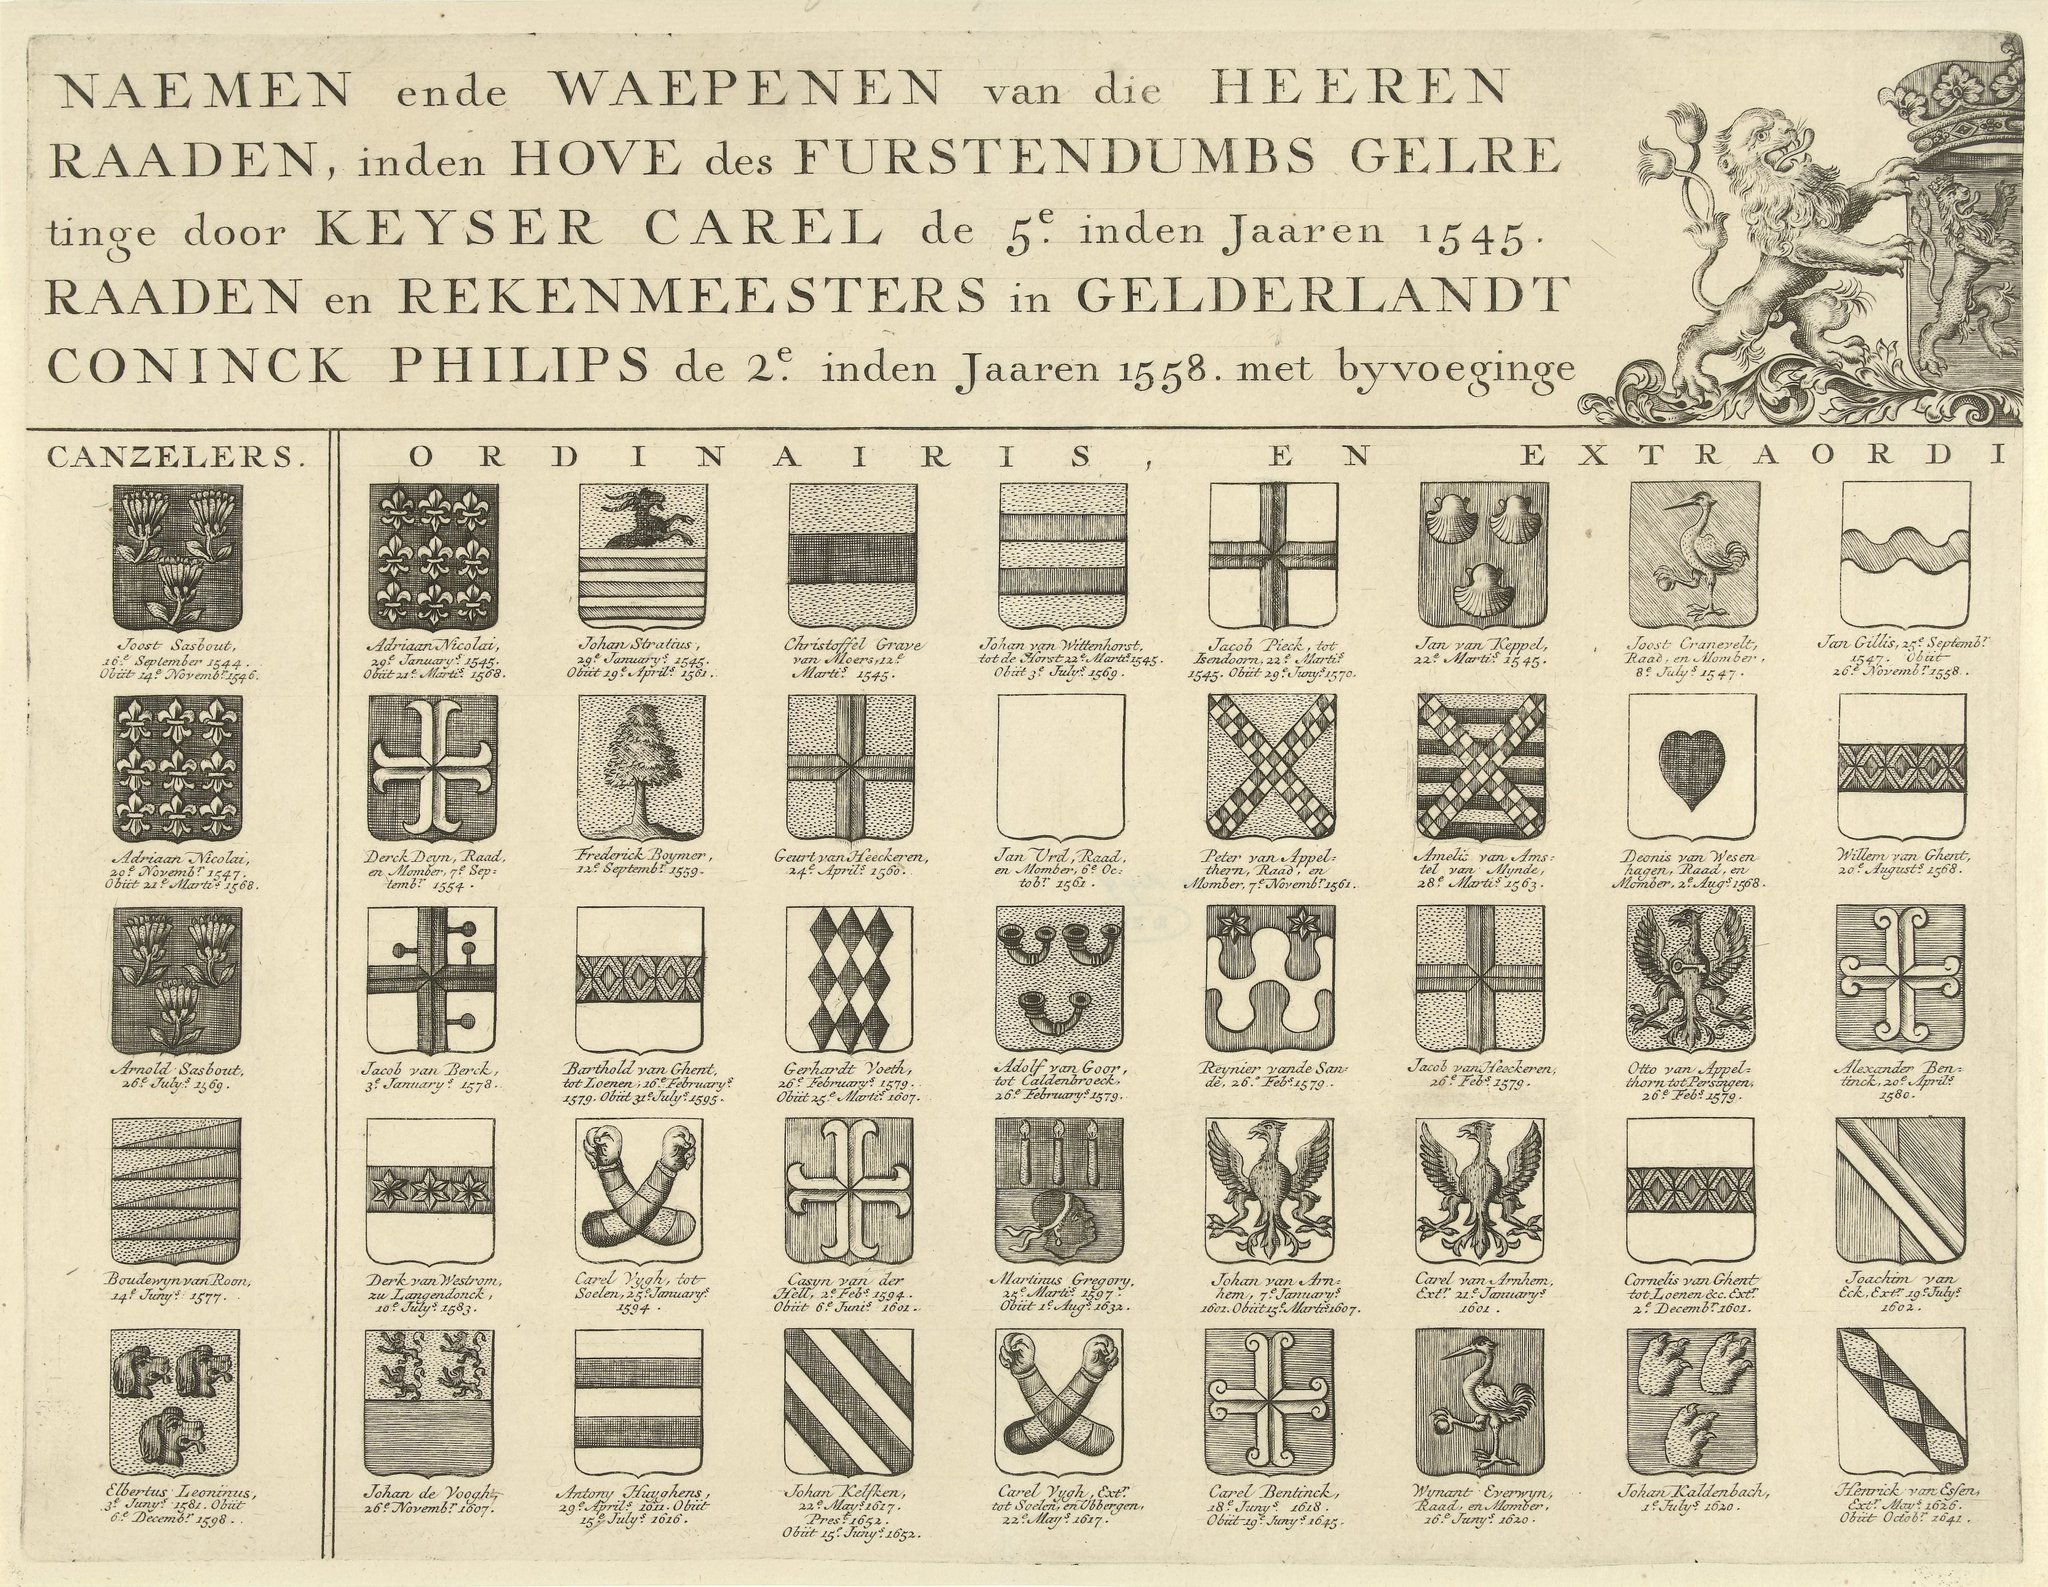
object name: print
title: Namen en wapens in het vorstendom Gelre en het graafschap Zutphen, blad linksboven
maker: wilhelmus ten haegh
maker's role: print maker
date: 1700-1799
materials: paper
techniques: engraving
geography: low countries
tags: armorial bearing, heraldry, gelderland, guelders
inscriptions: collector's mark: Lugt 2228